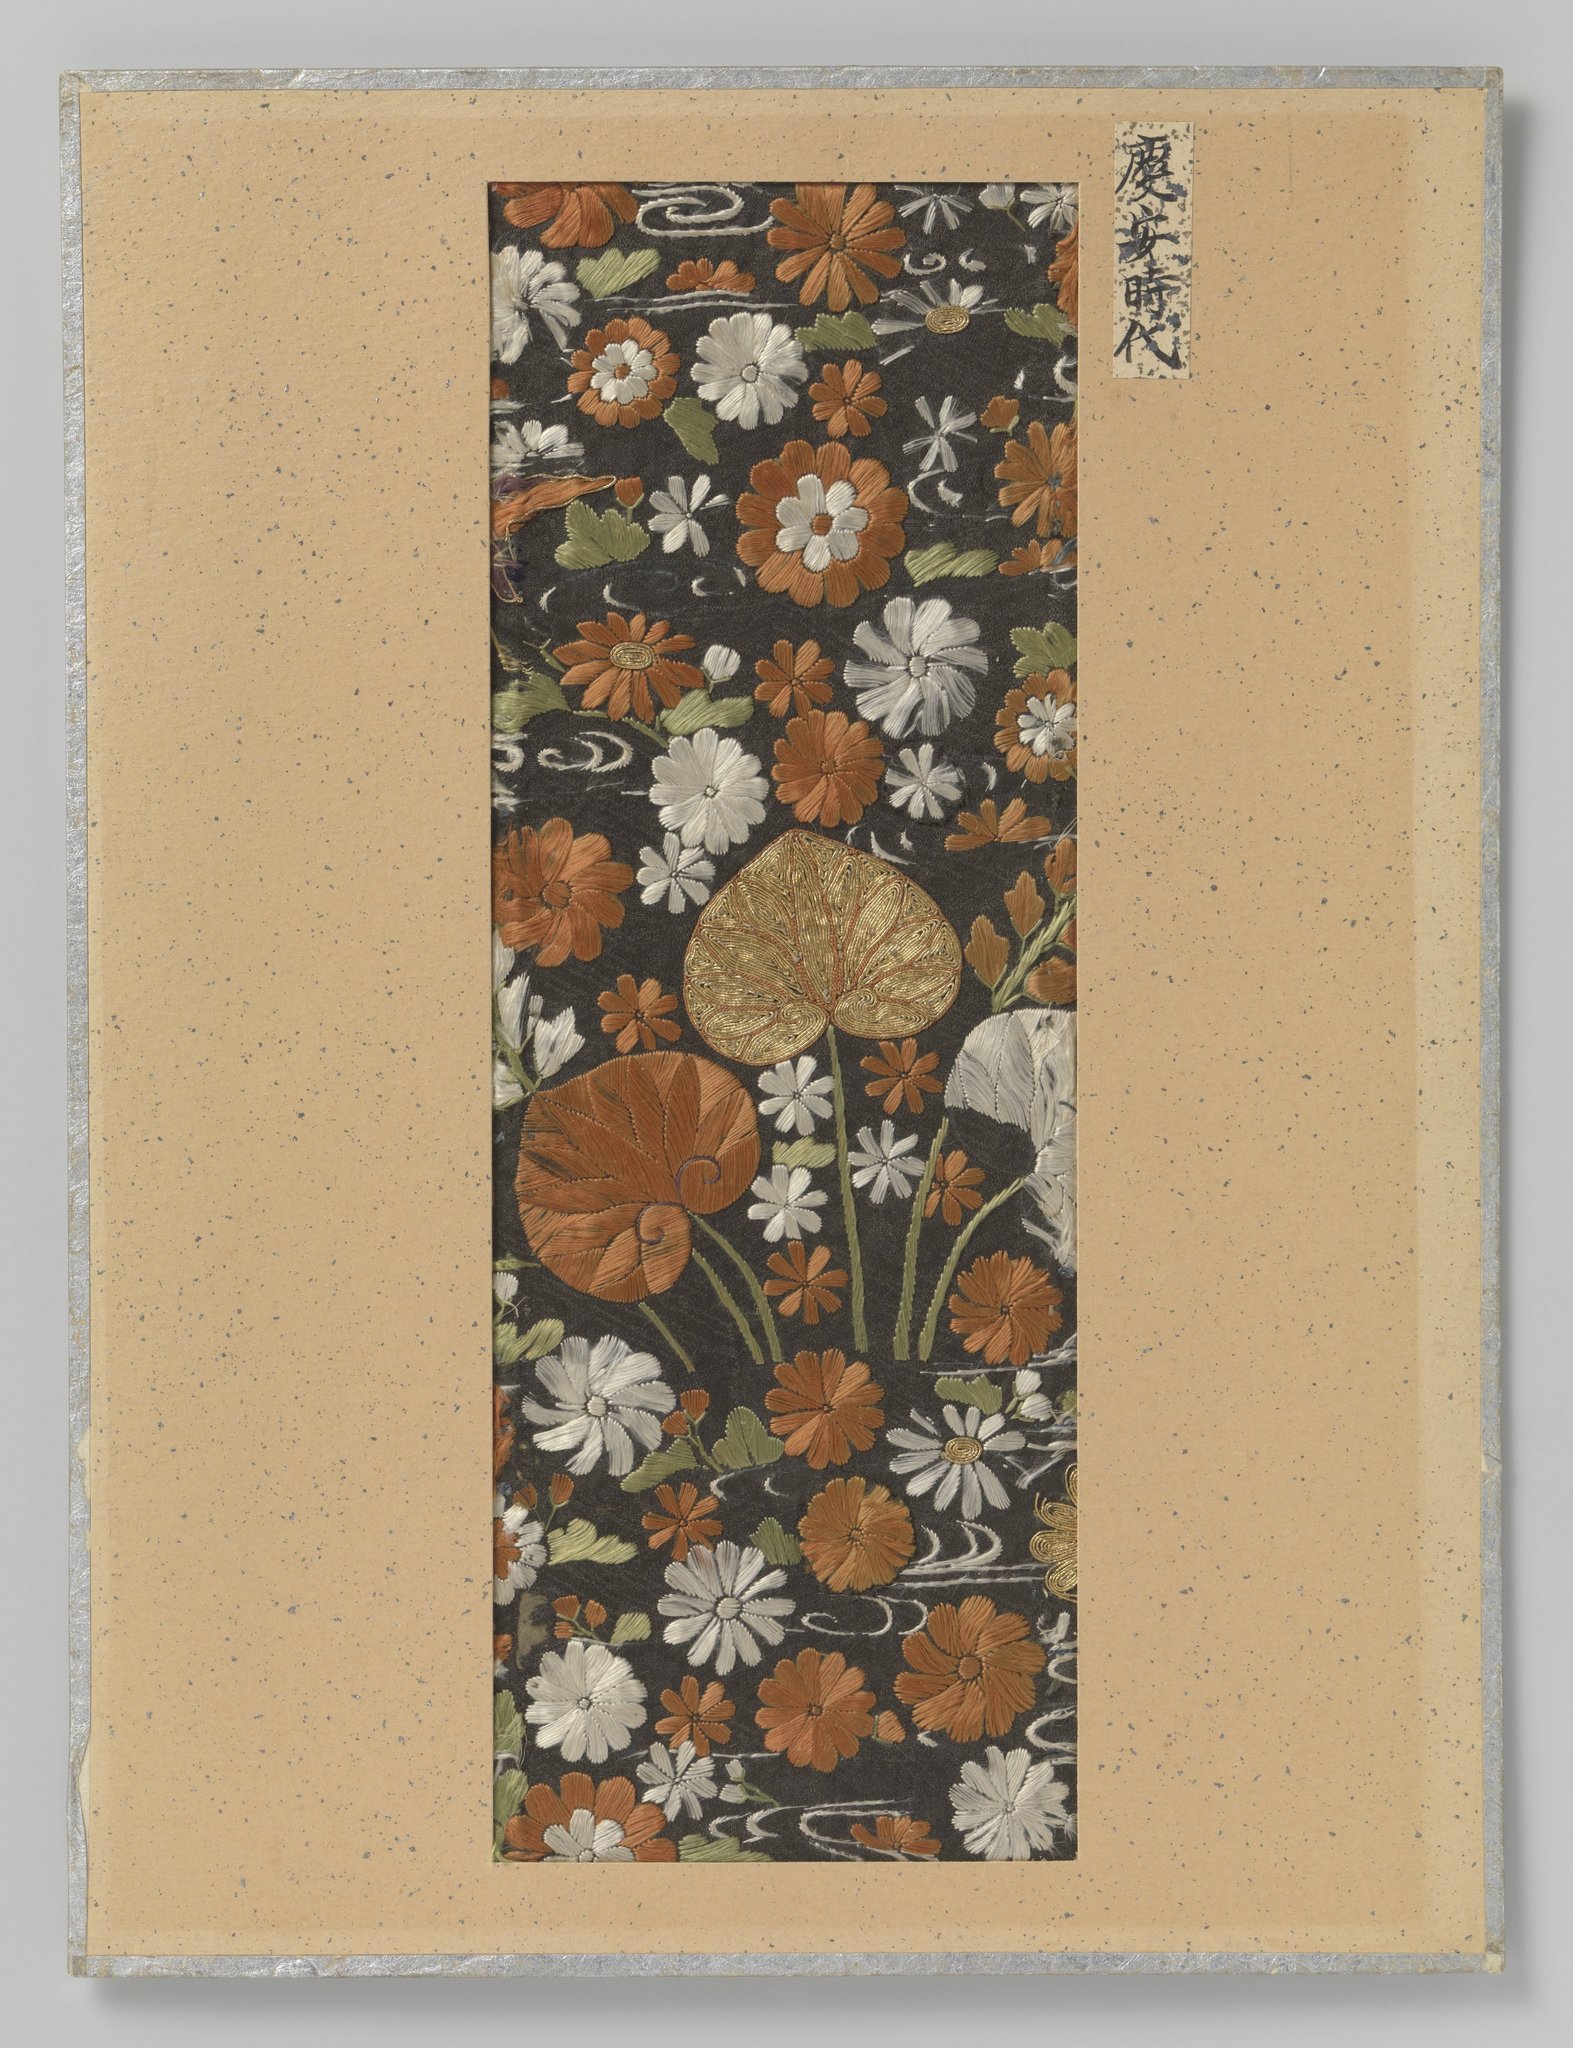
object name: fragment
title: Fragment textiel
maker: Anonymous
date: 1648-1652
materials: silk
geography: japan